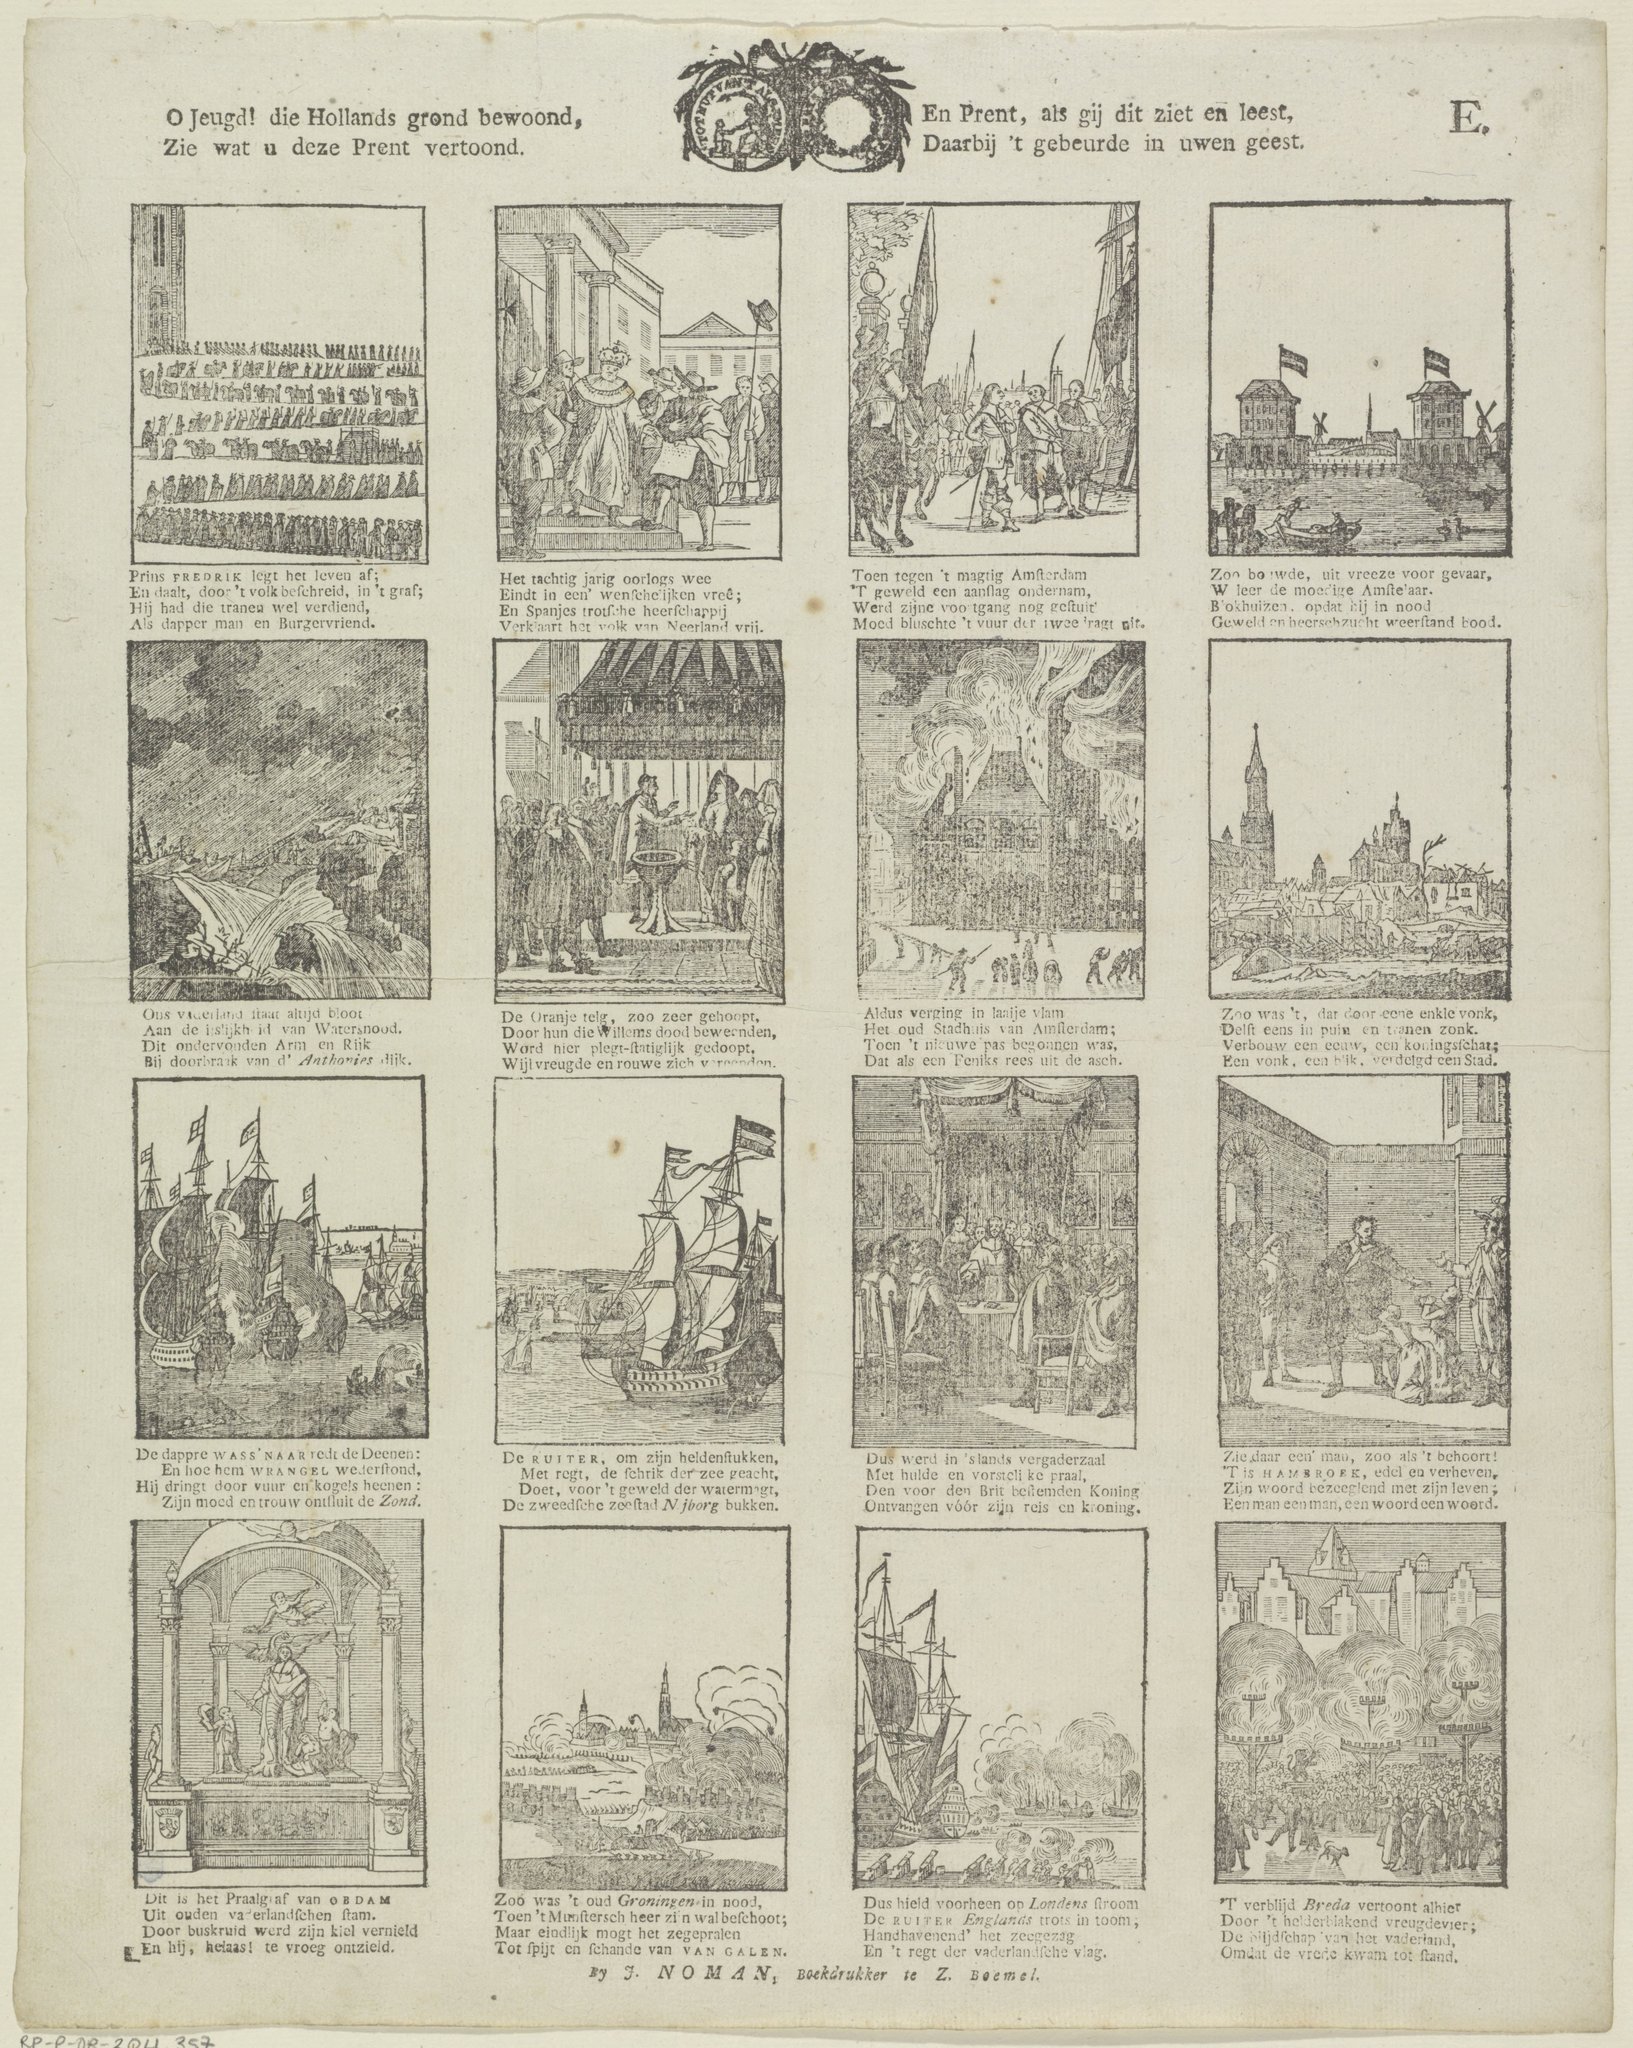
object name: print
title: O jeugd! die Hollands grond bewoond, / Zie wat u deze prent vertoond. / En prent, als gij dit ziet en leest, / Daarbij 't gebeurde in uwen geest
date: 1806-1830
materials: paper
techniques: letterpress printing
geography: zaltbommel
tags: formosa, flushing, michiel adriaenszoon de ruyter, jacob baron van wassenaer heer van obdam, delft, the hague, frederick henry (prince of orange), essen, history, grave-building, monumental tomb, london, low countries, amsterdam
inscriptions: collector's mark: Lugt 2760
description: Blad met 16 voorstellingen van gebeurtenissen uit de vaderlandse geschiedenis, zoals het einde van de Tachtigjarige Oorlog en de brand in het oude stadhuis van Amsterdam. Onder elke afbeelding een vierregelig vers. Midden boven het zegel van de Maatschappij tot Nut van 't Algemeen. Gemerkt rechtsboven: E.